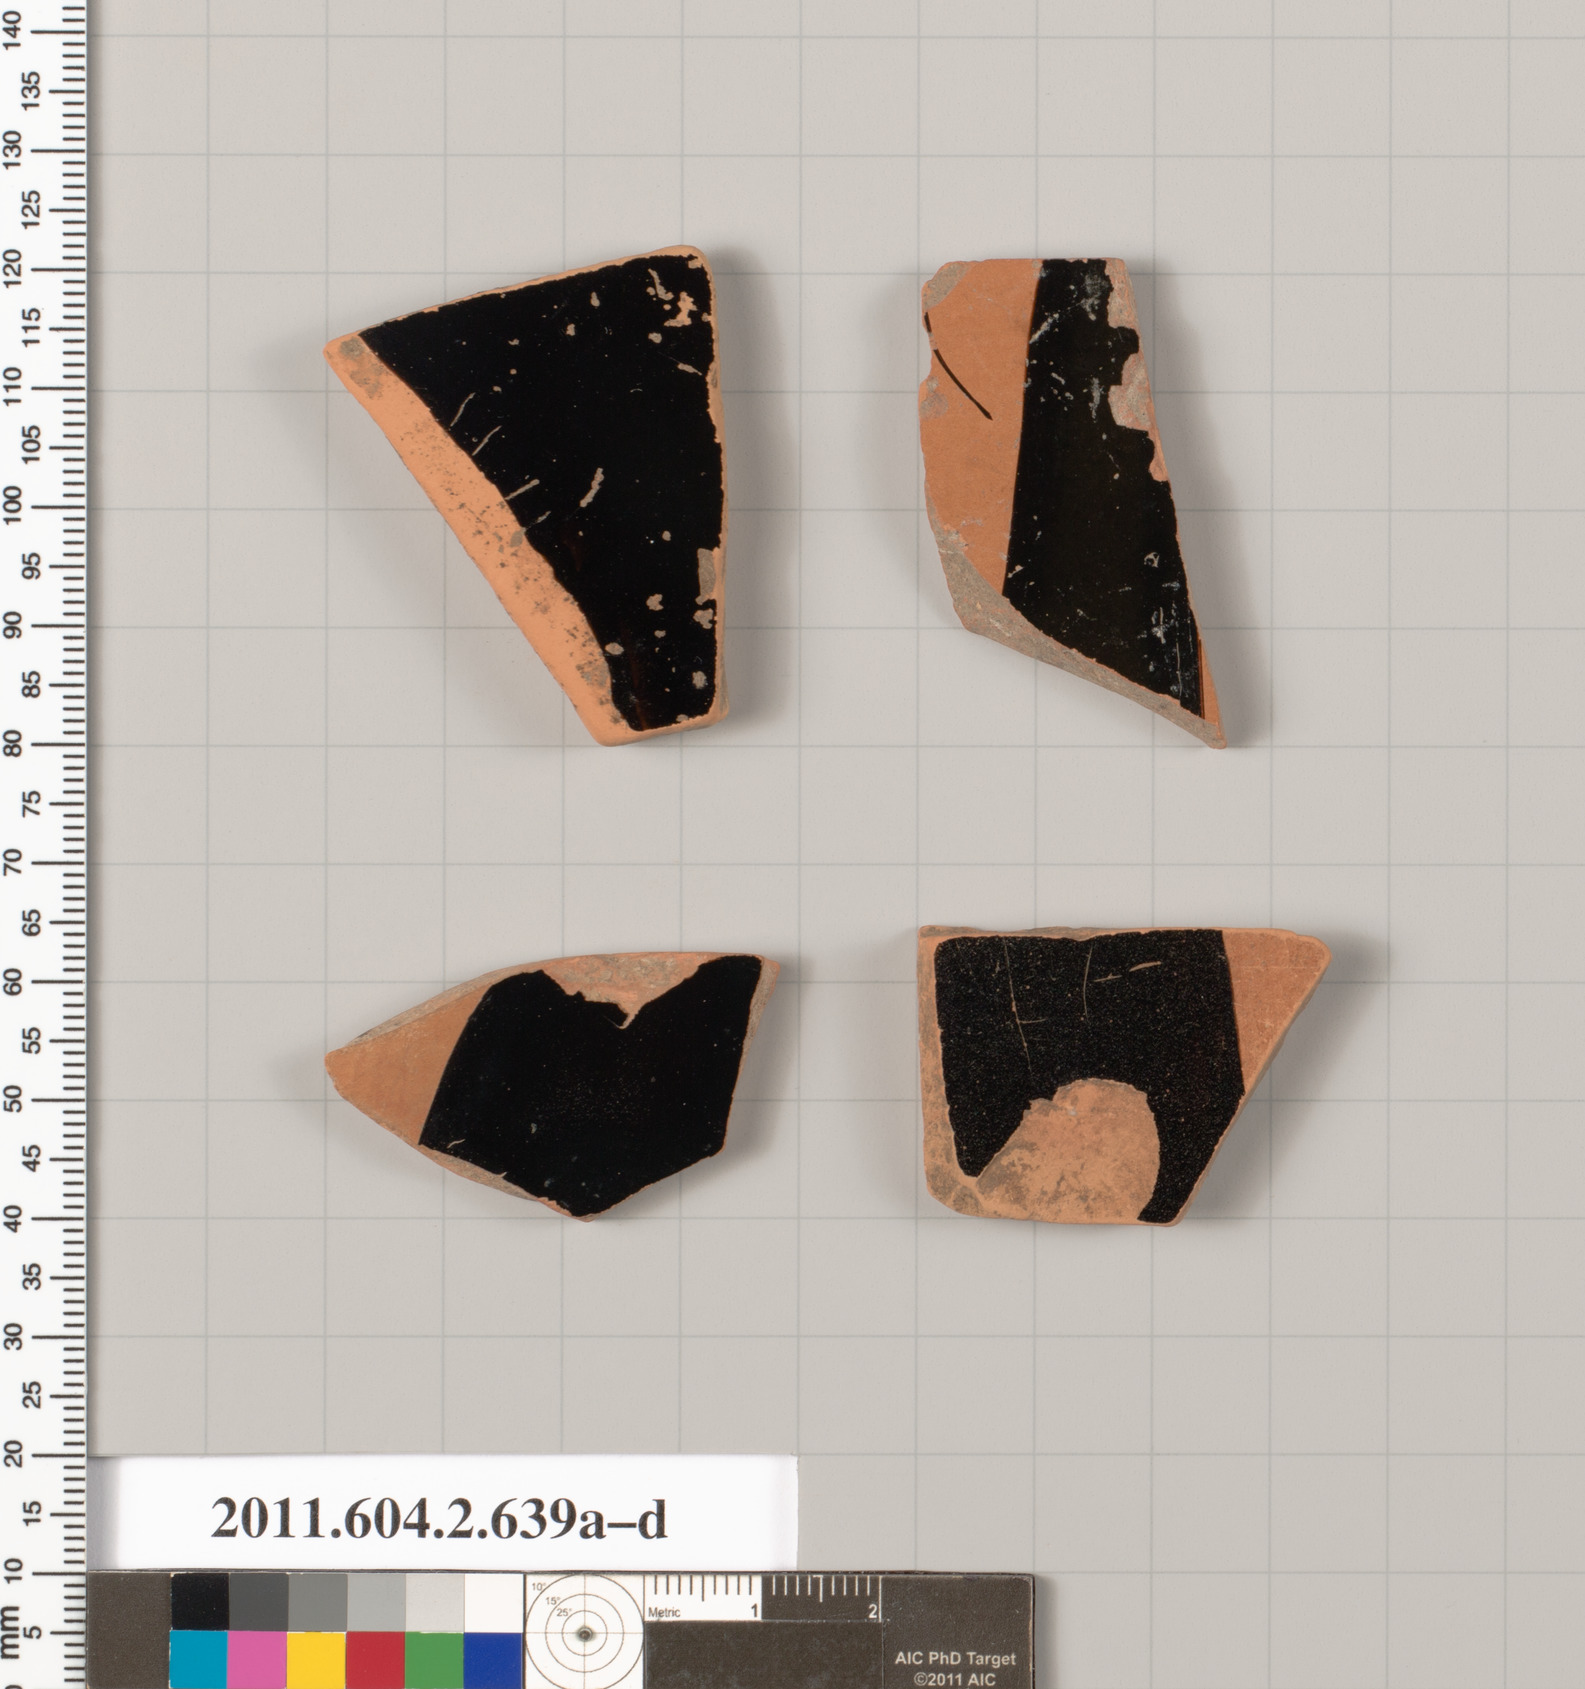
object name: column krater fragment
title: Terracotta fragments of column-kraters (bowls for mixing wine and water)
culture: greek, attic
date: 460-440 BCE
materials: terracotta